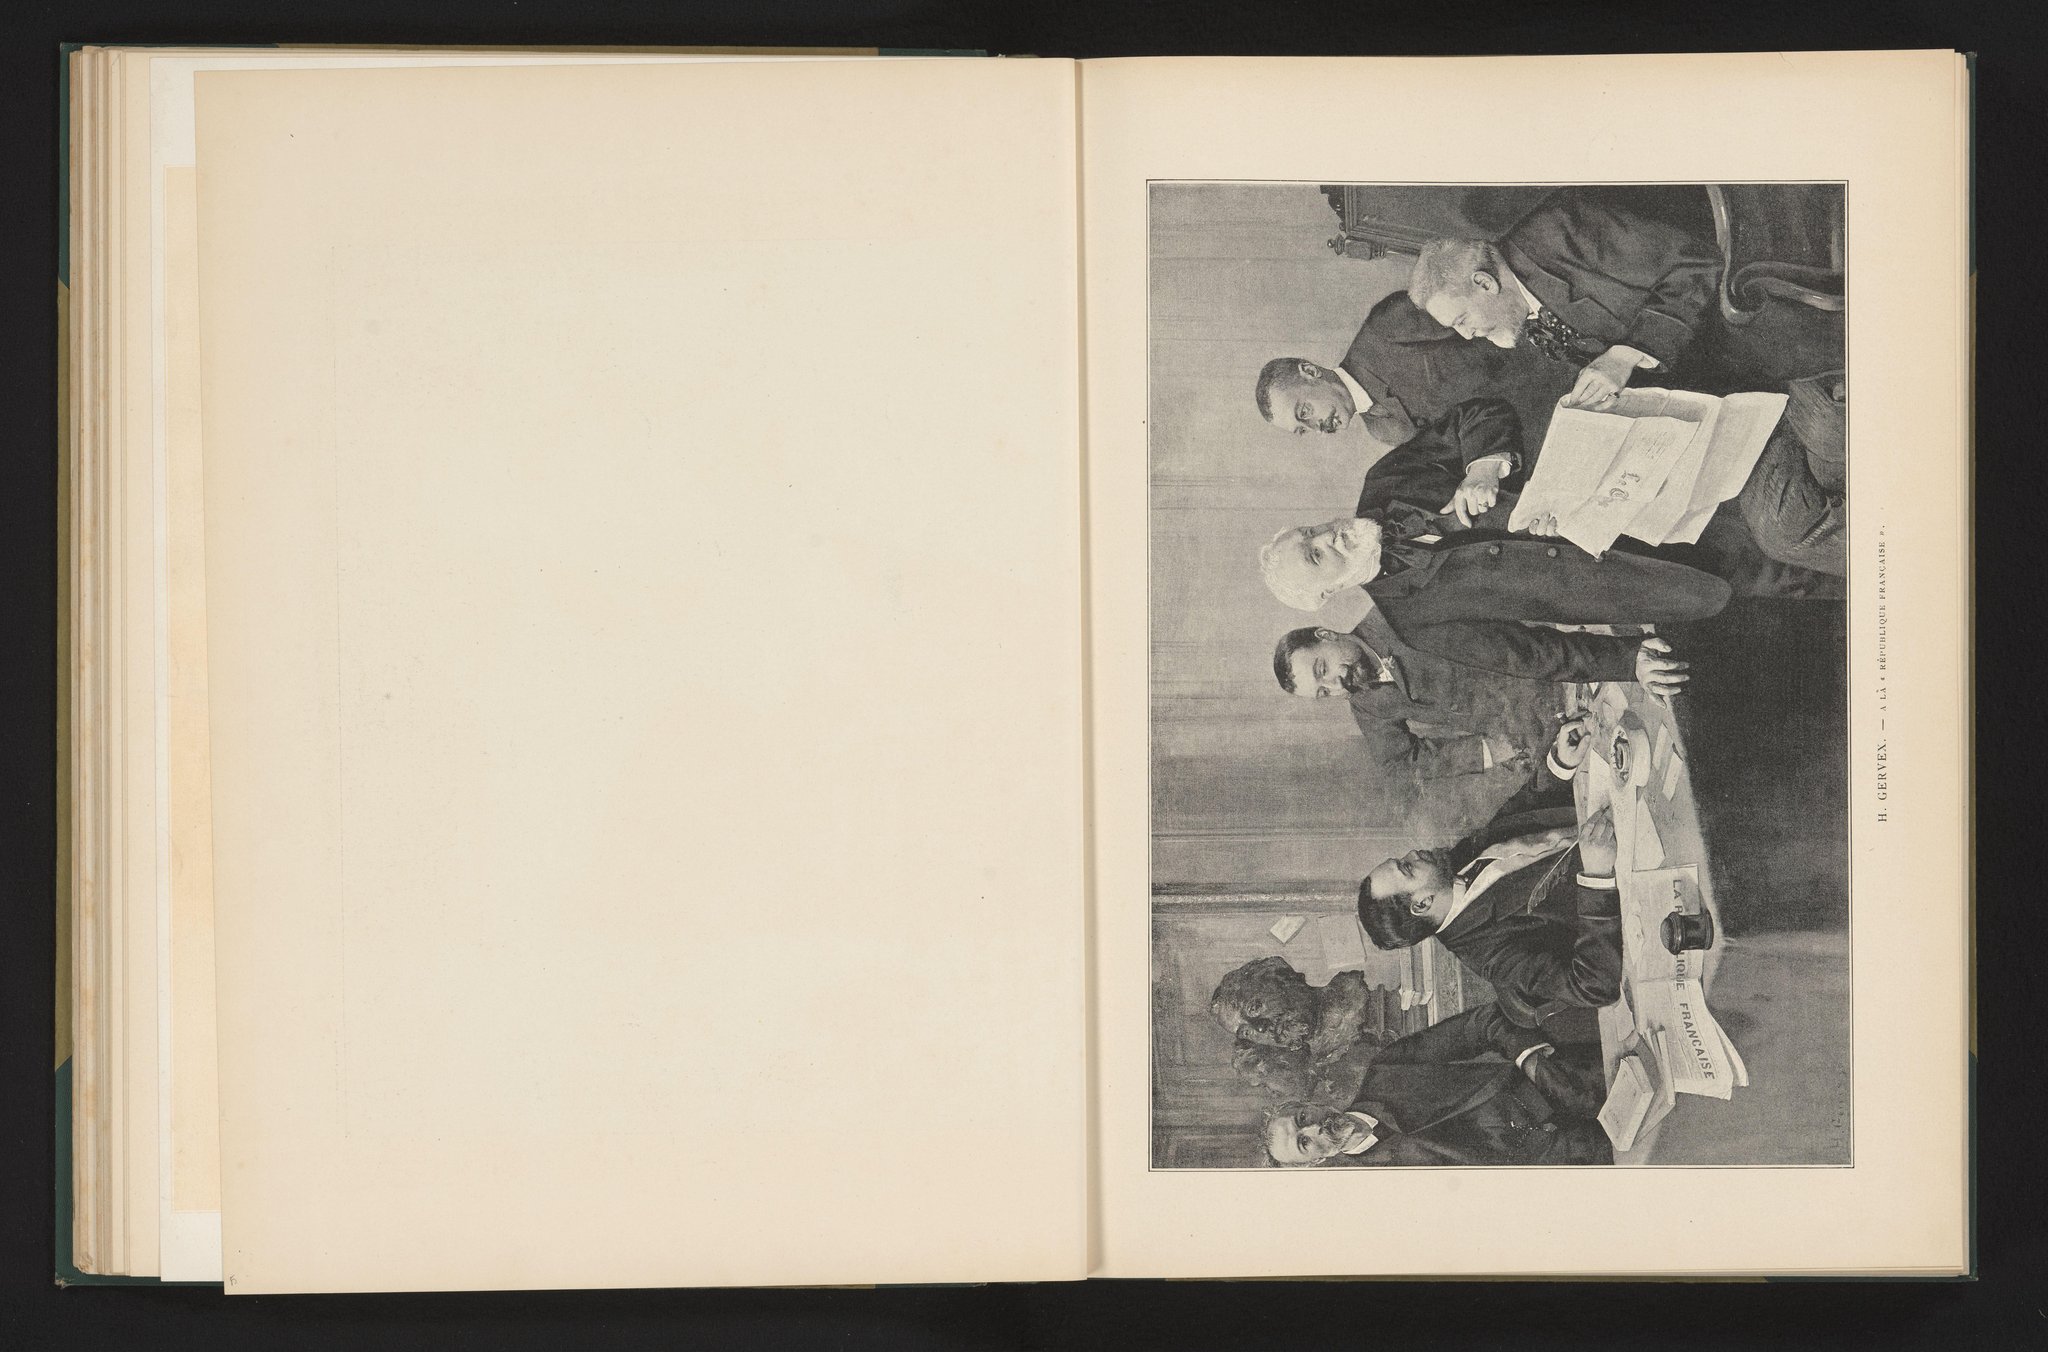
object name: photomechanical print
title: Reproductie van De Franse republiek door Henri Gervex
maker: Anonymous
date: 1885-1901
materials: paper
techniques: autotype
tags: newspaper, news-sheet